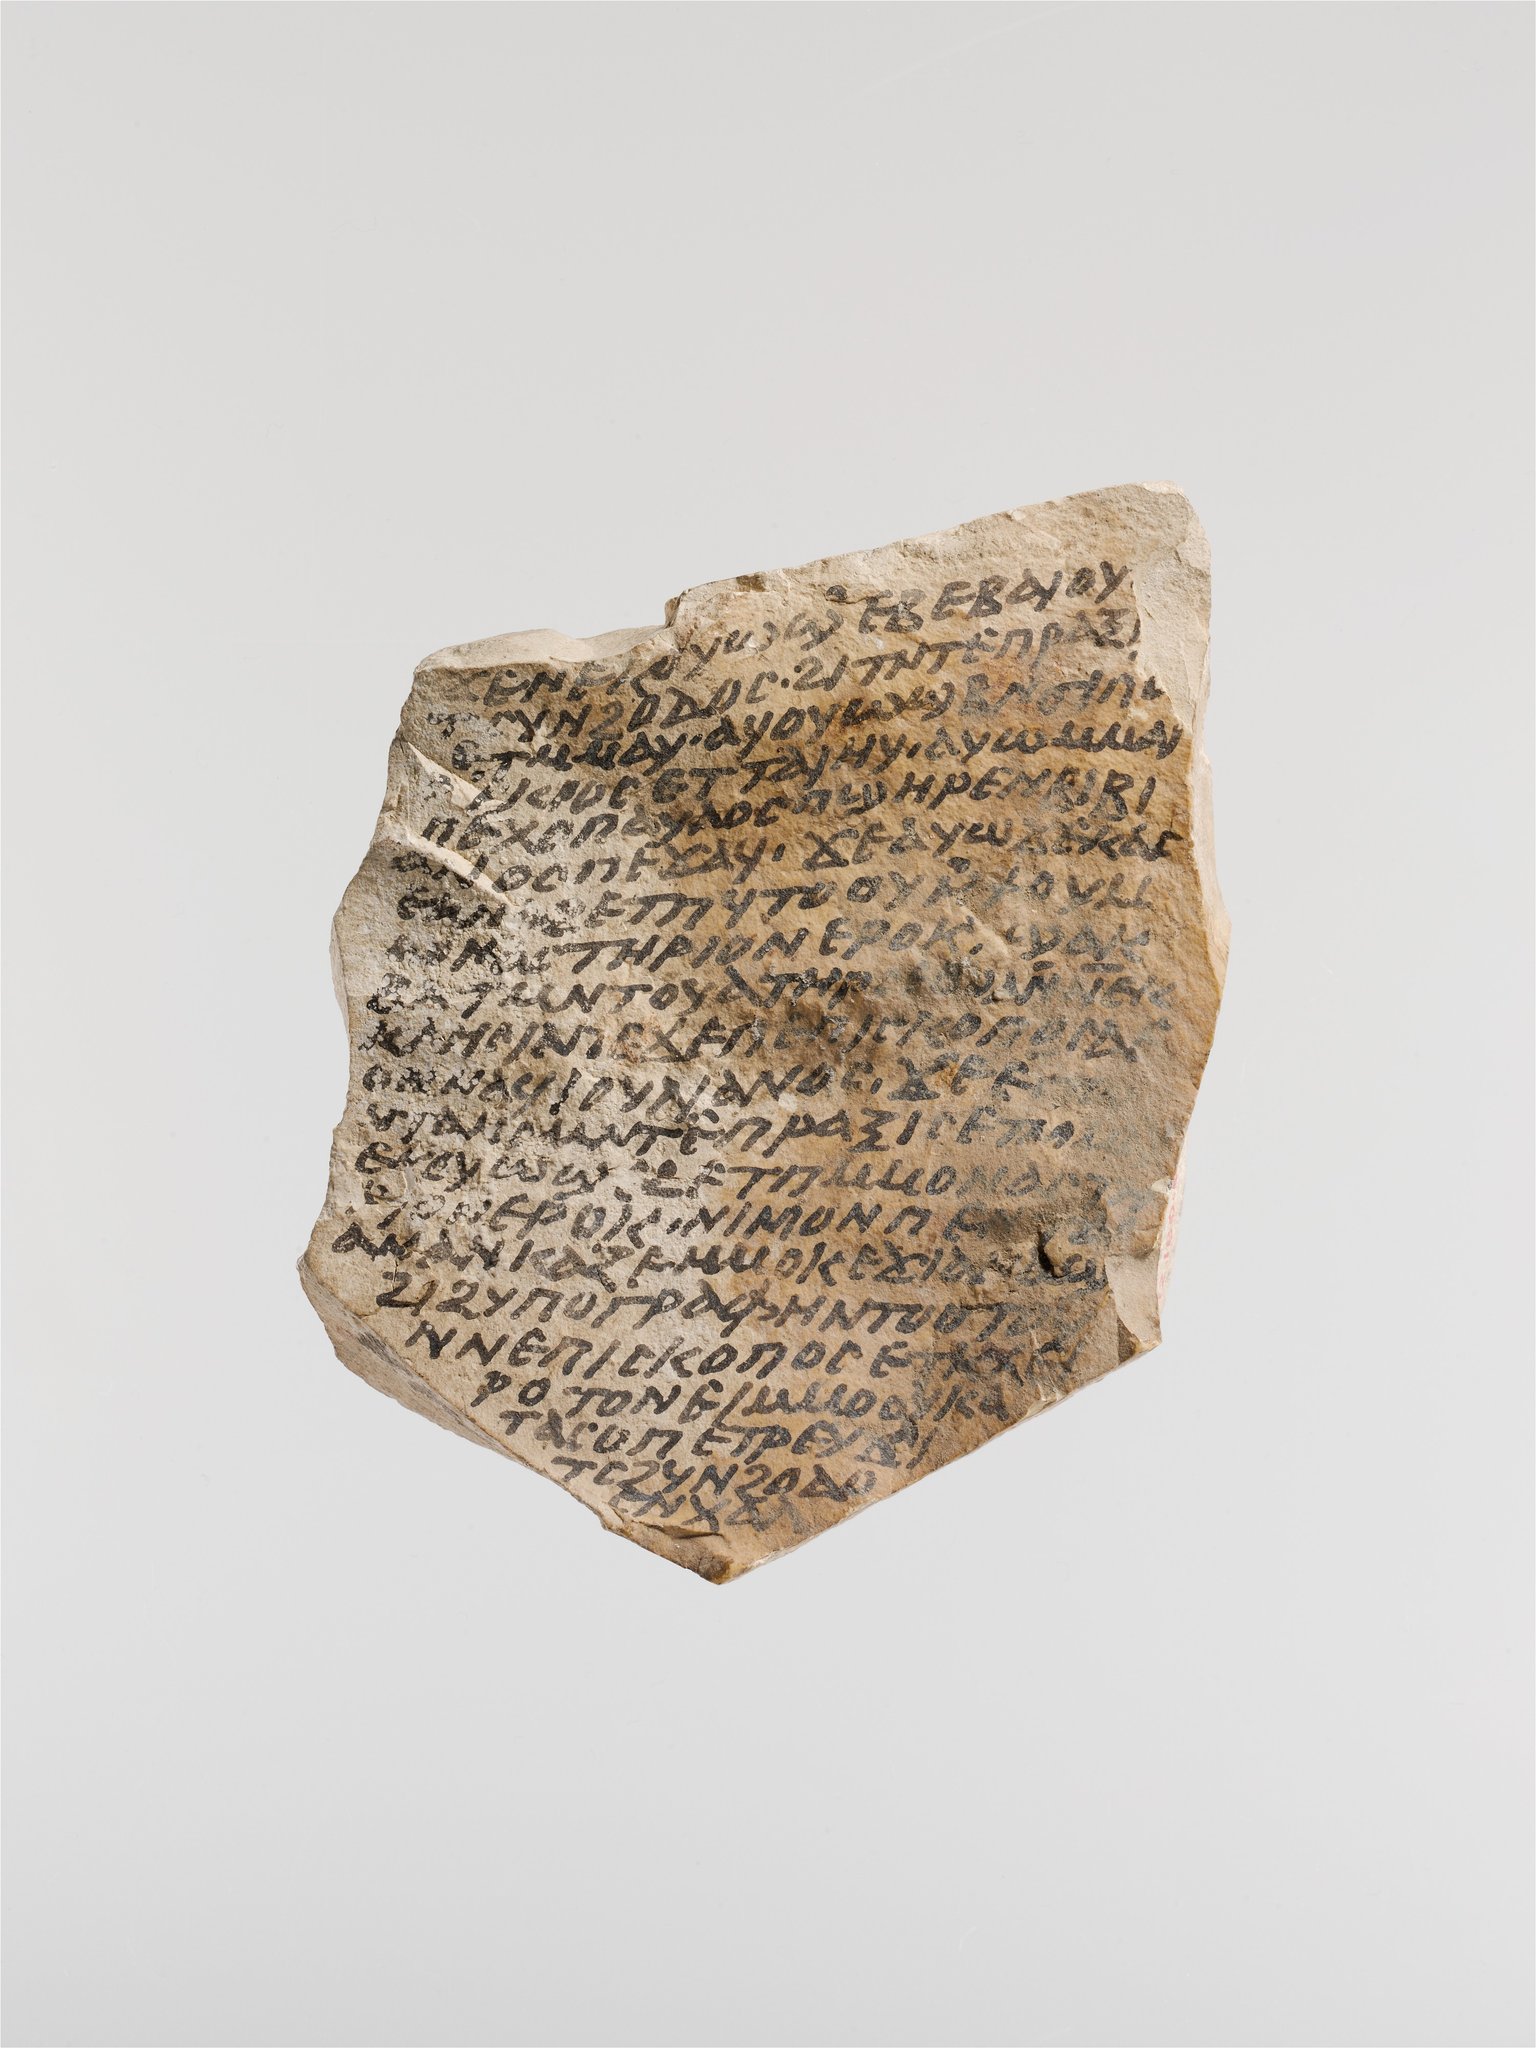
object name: ostrakon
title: Ostrakon with an Epistle of Severos, Bishop of Antioch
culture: coptic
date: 508-640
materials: ink, limestone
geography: egypt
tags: documents